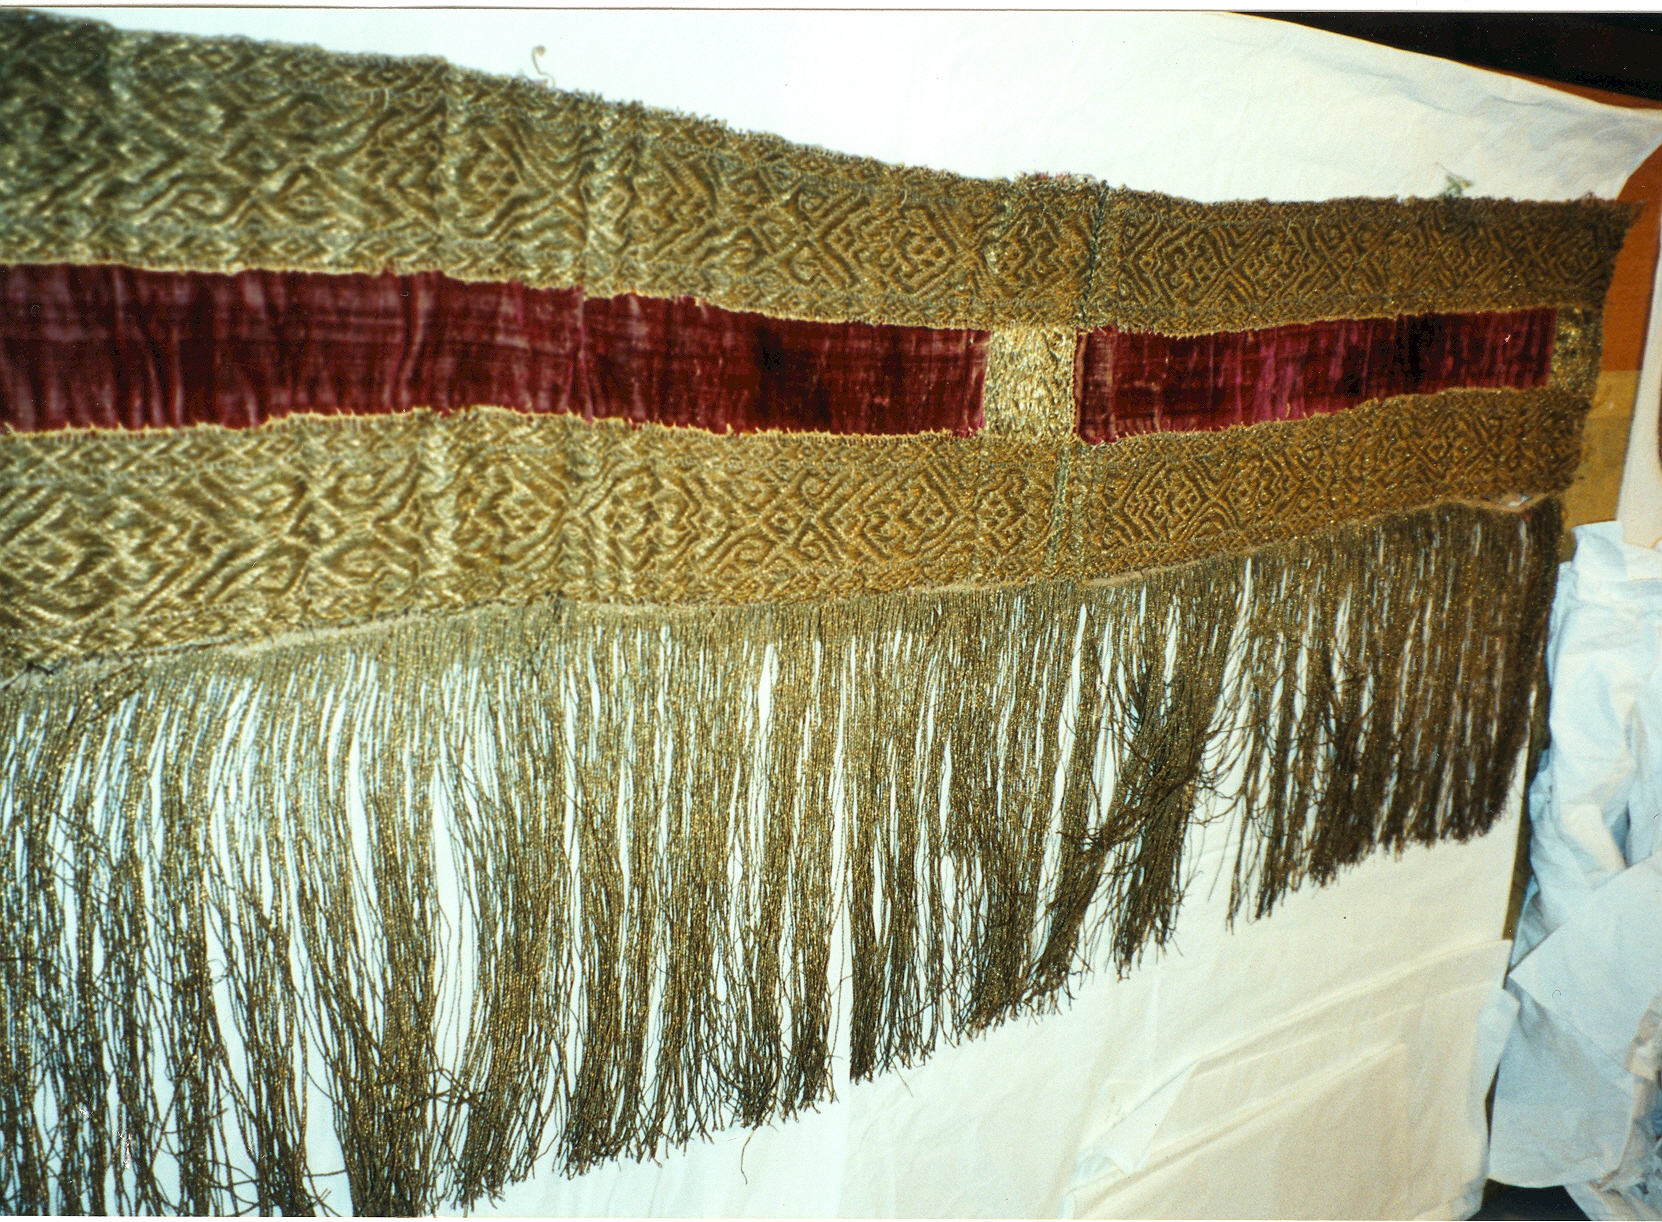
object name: textile border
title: Border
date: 1801-1900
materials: linen, metal, silk